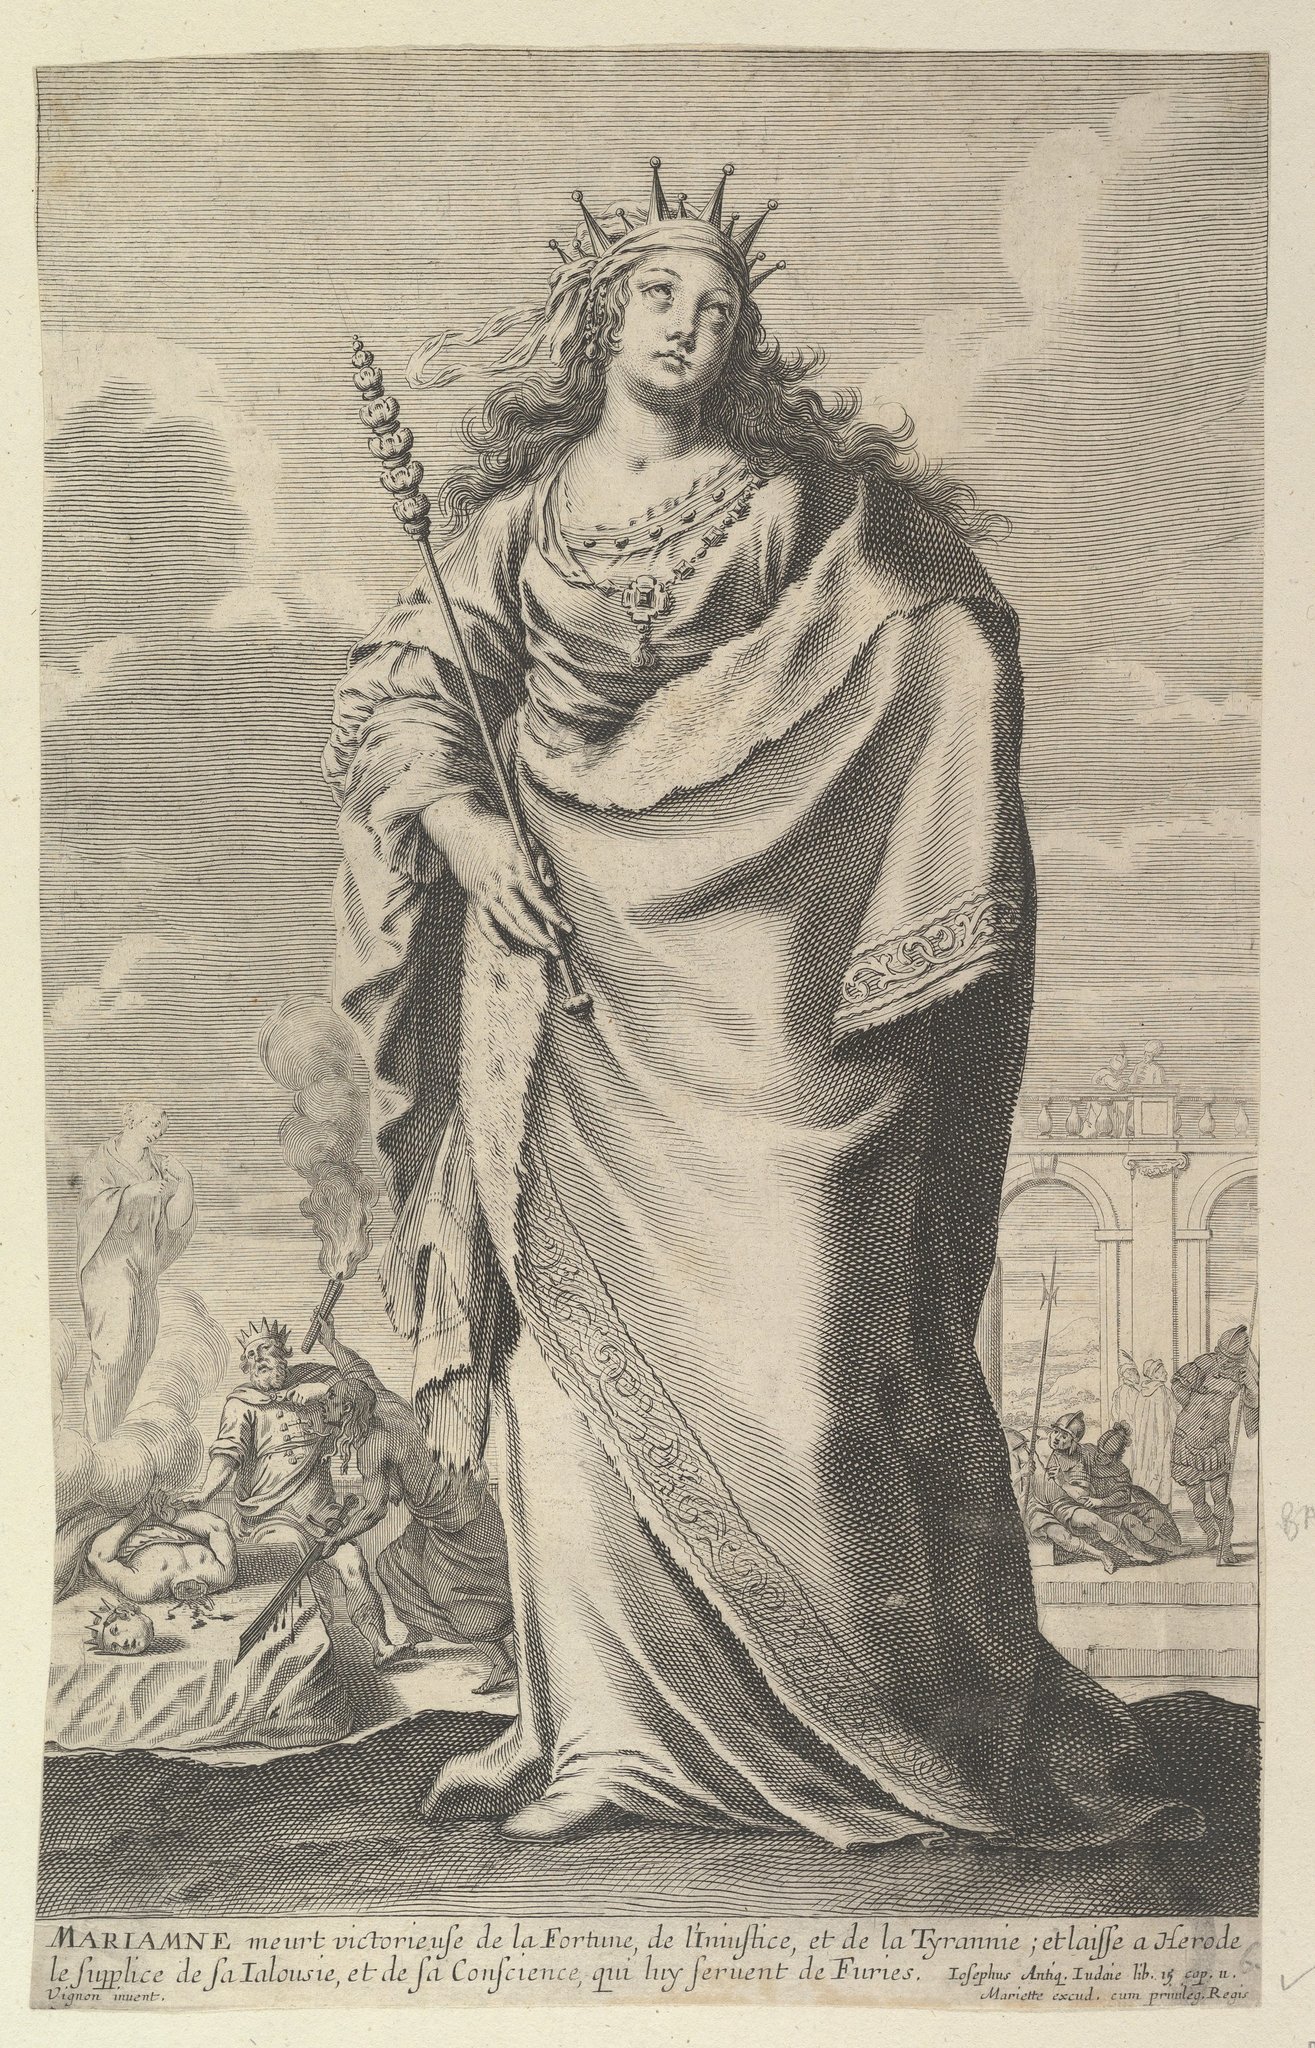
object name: print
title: Marianne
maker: gilles rousselet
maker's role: artist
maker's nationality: french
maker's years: 1614-1686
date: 1647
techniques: engraving, etching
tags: women